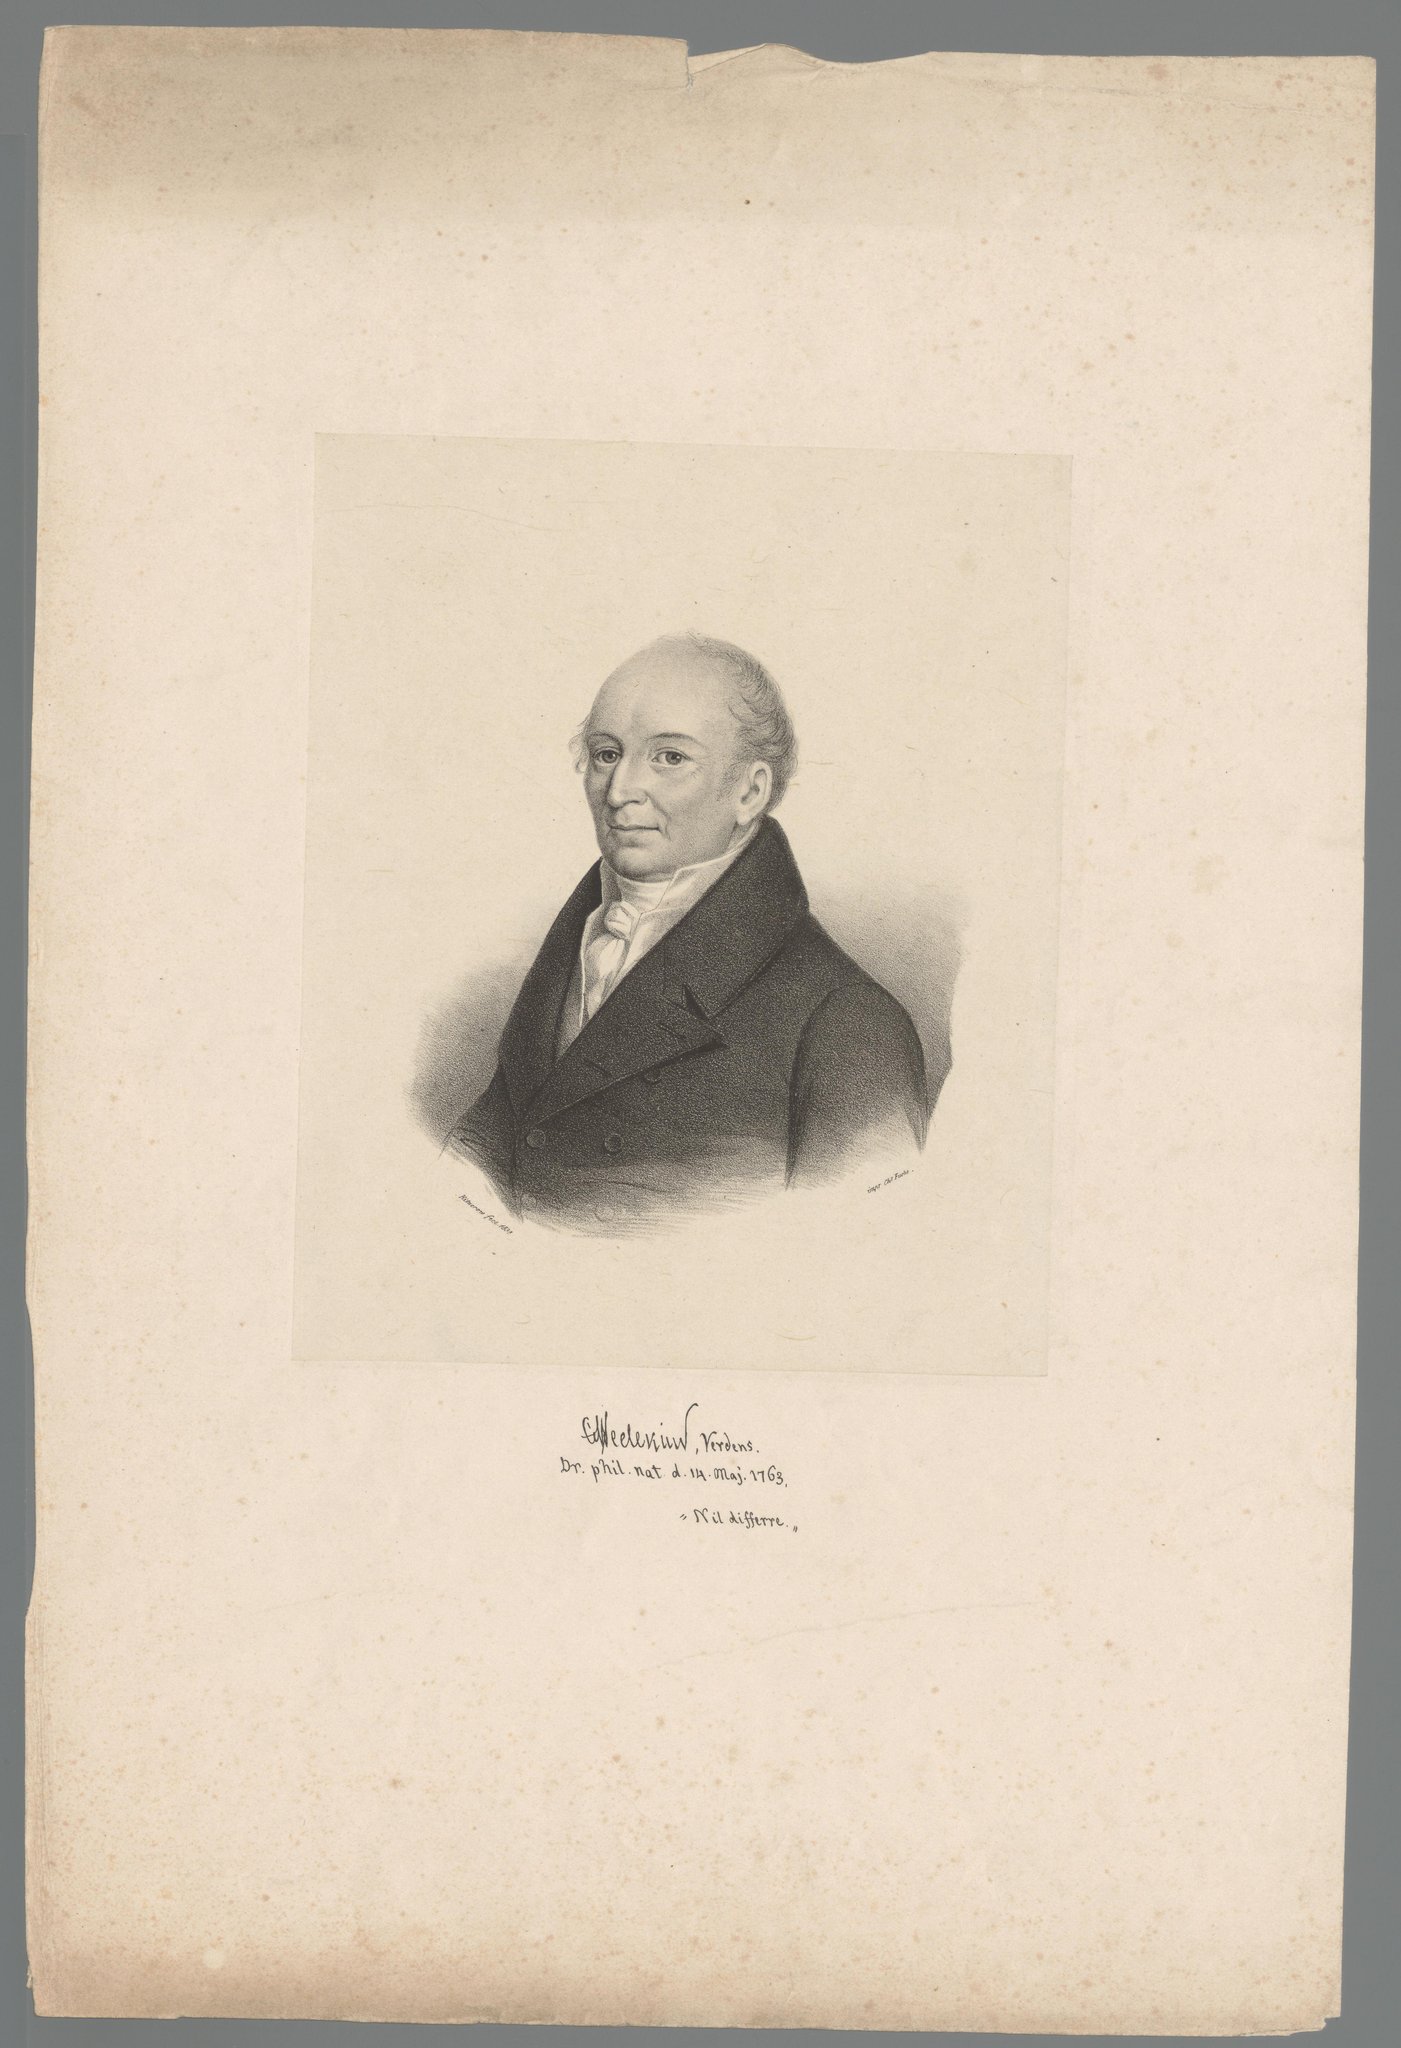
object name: print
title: Portret van Anton Christian Wedekind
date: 1838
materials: paper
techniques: lithograph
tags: adult man, historical persons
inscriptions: collector's mark: Lugt 2228